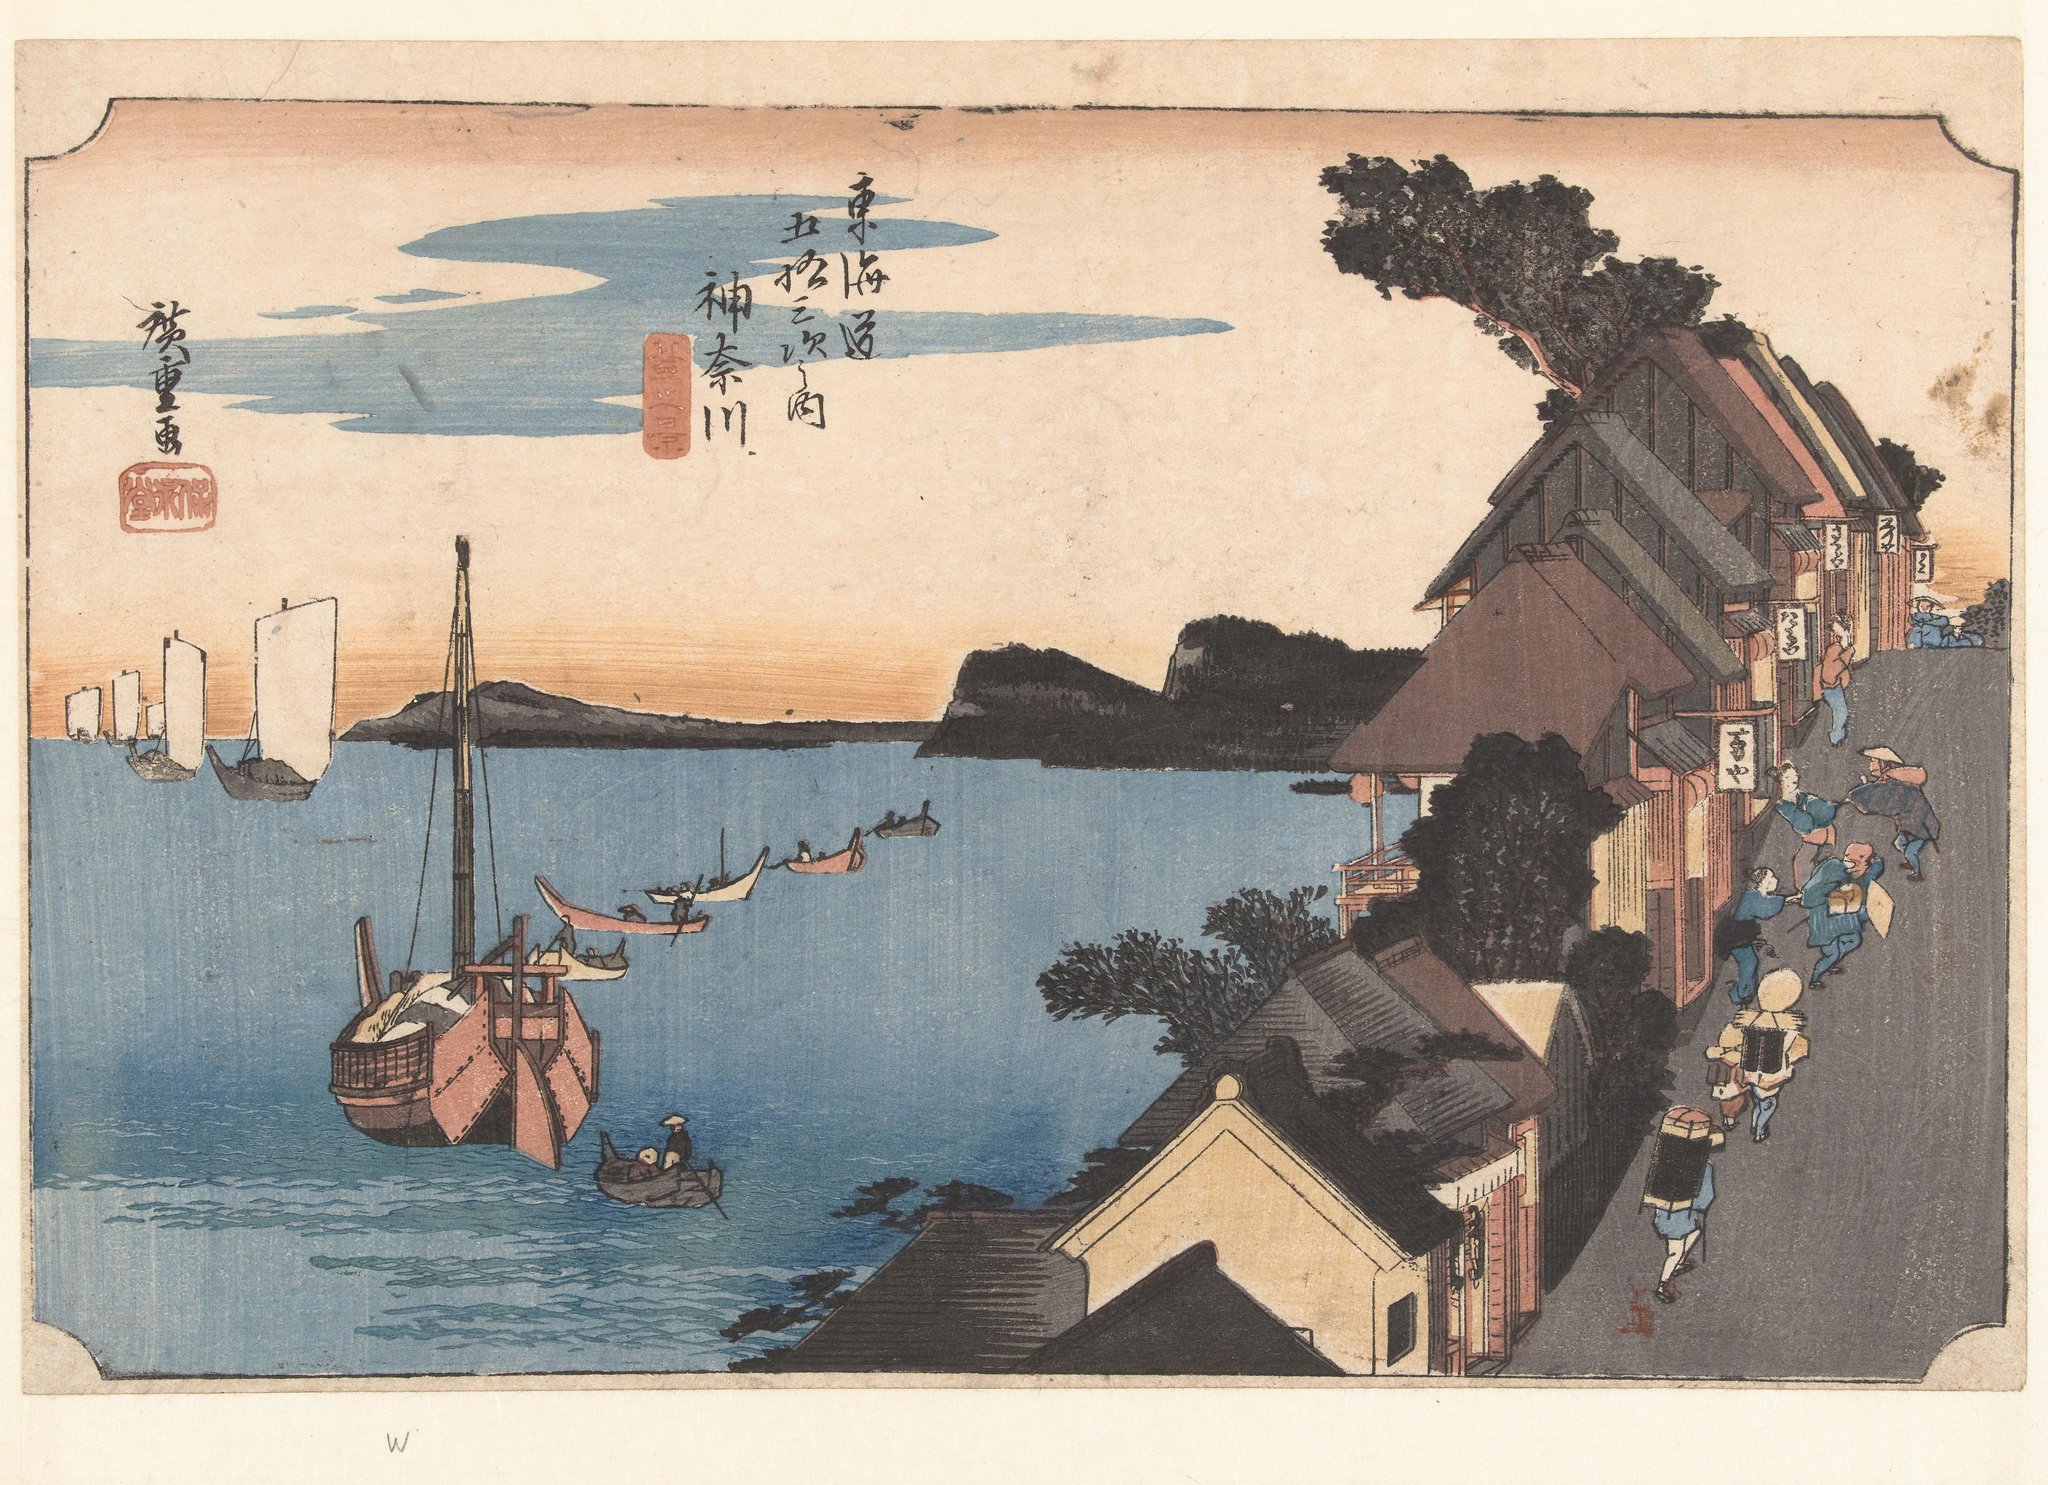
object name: print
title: Kanagawa, dai no kei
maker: utagawa hiroshige (i)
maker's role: draughtsman, print maker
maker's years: 1797-1858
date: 1828-1835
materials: paper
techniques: woodcut, nishiki e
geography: japan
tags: lake, (high) hill (+ landscape with figures, staffage)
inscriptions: collector's mark: Lugt 2228, signature: ‘Hiroshige ga’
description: Gezicht op een meer met bootjes en een stijle weg omhoog waarlangs verschillende theehuizen waarvan de serveersters reizigers naar binnen proberen te trekken.